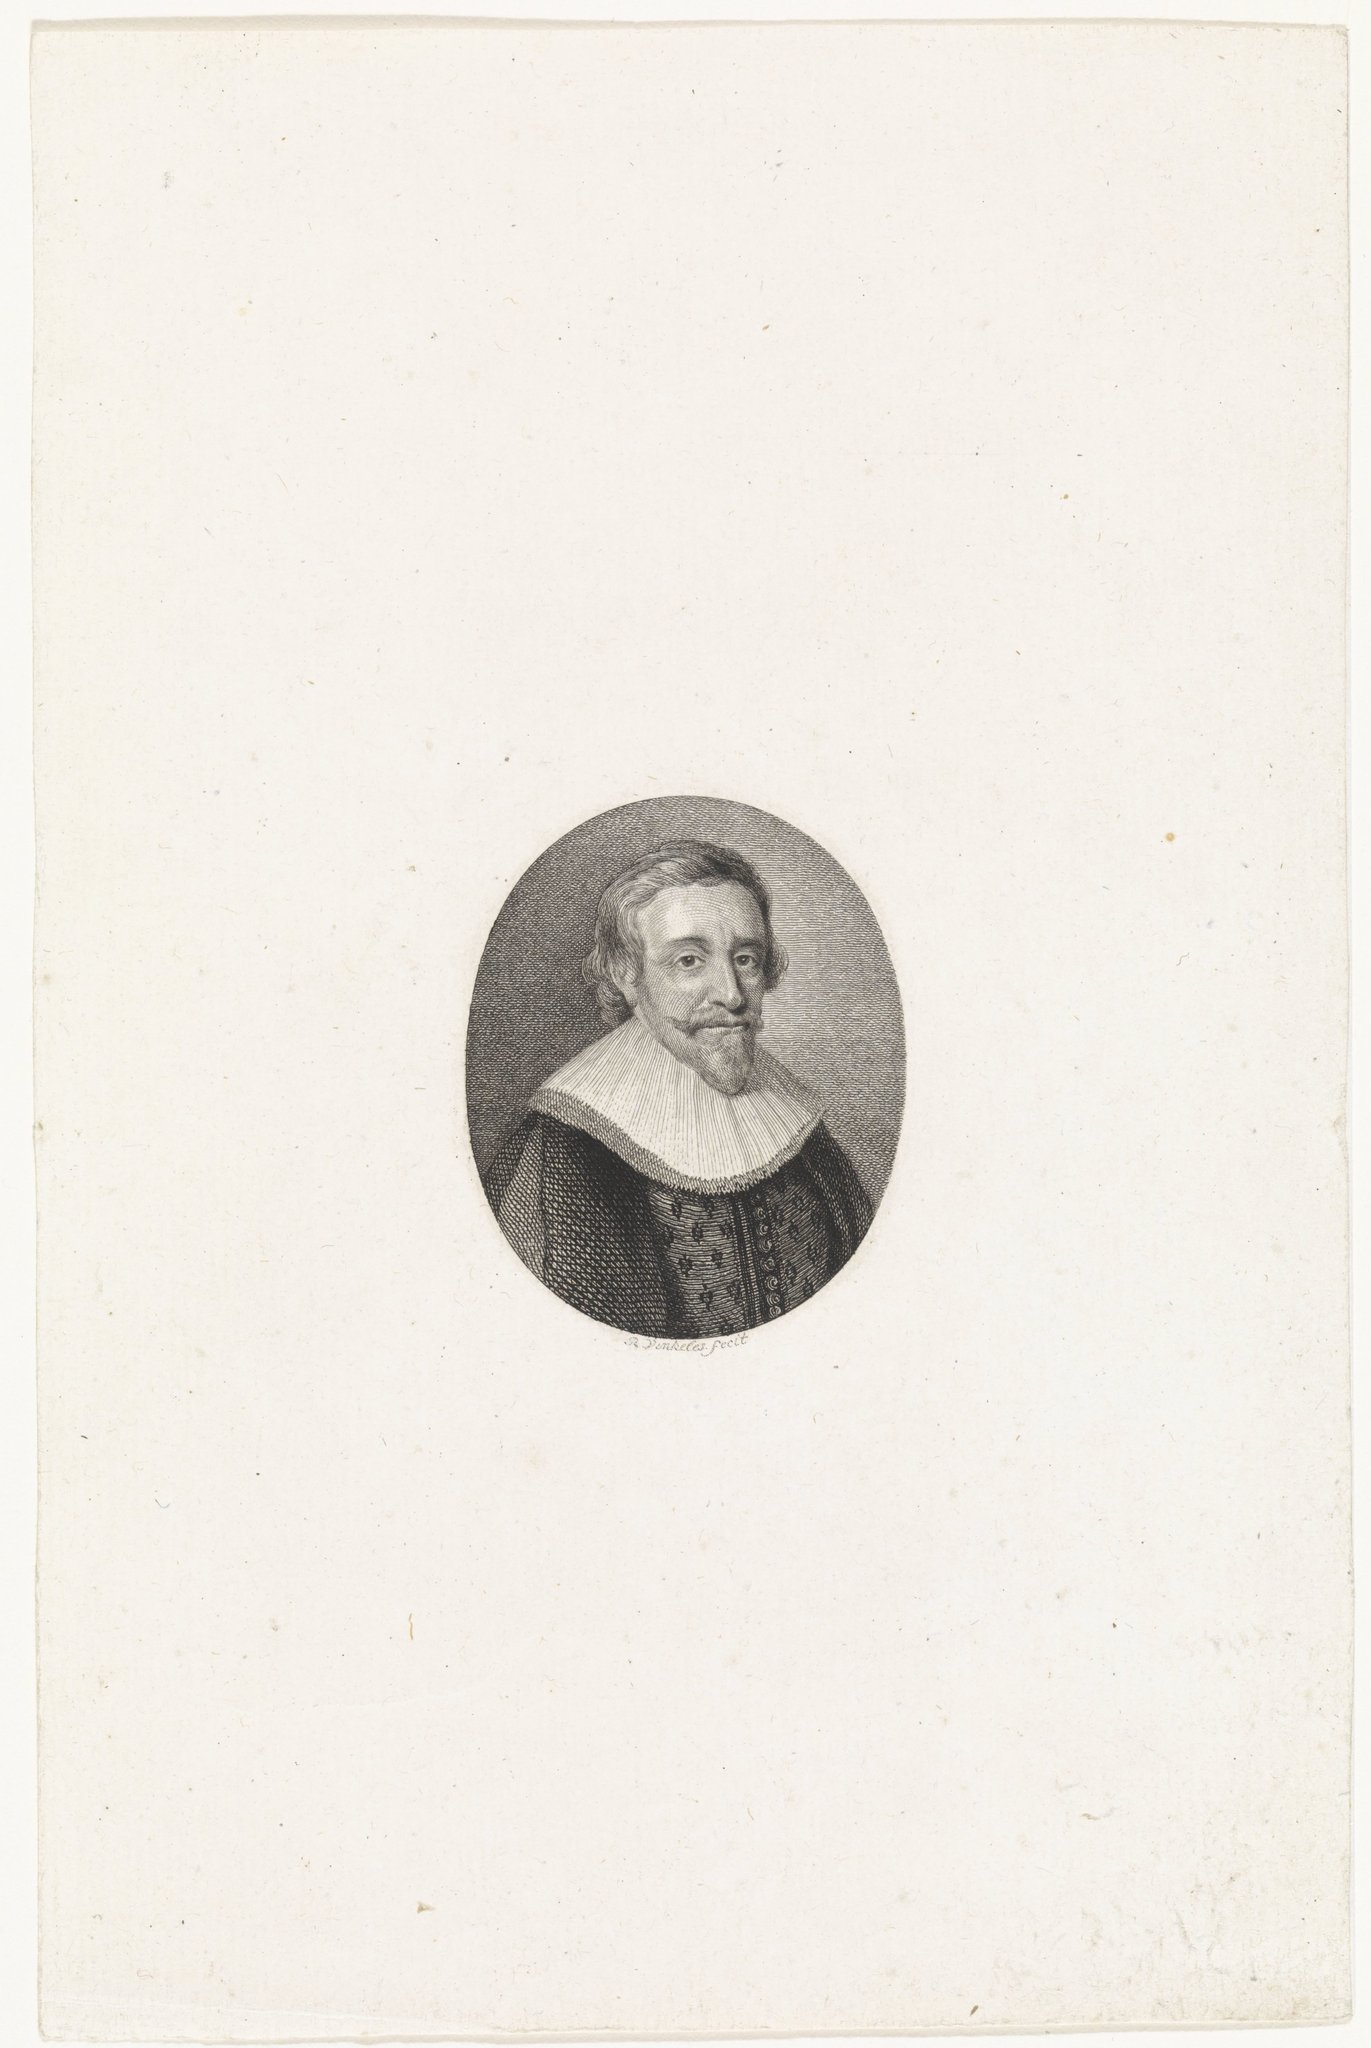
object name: print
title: Portret van Hugo de Groot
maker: reinier vinkeles (i)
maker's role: draughtsman, print maker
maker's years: 1741-1816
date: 1751-1816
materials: paper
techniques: engraving, etching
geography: amsterdam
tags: delft, hugo de groot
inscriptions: collector's mark: Lugt 2228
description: Portret van de rechtsgeleerde Hugo de Groot.